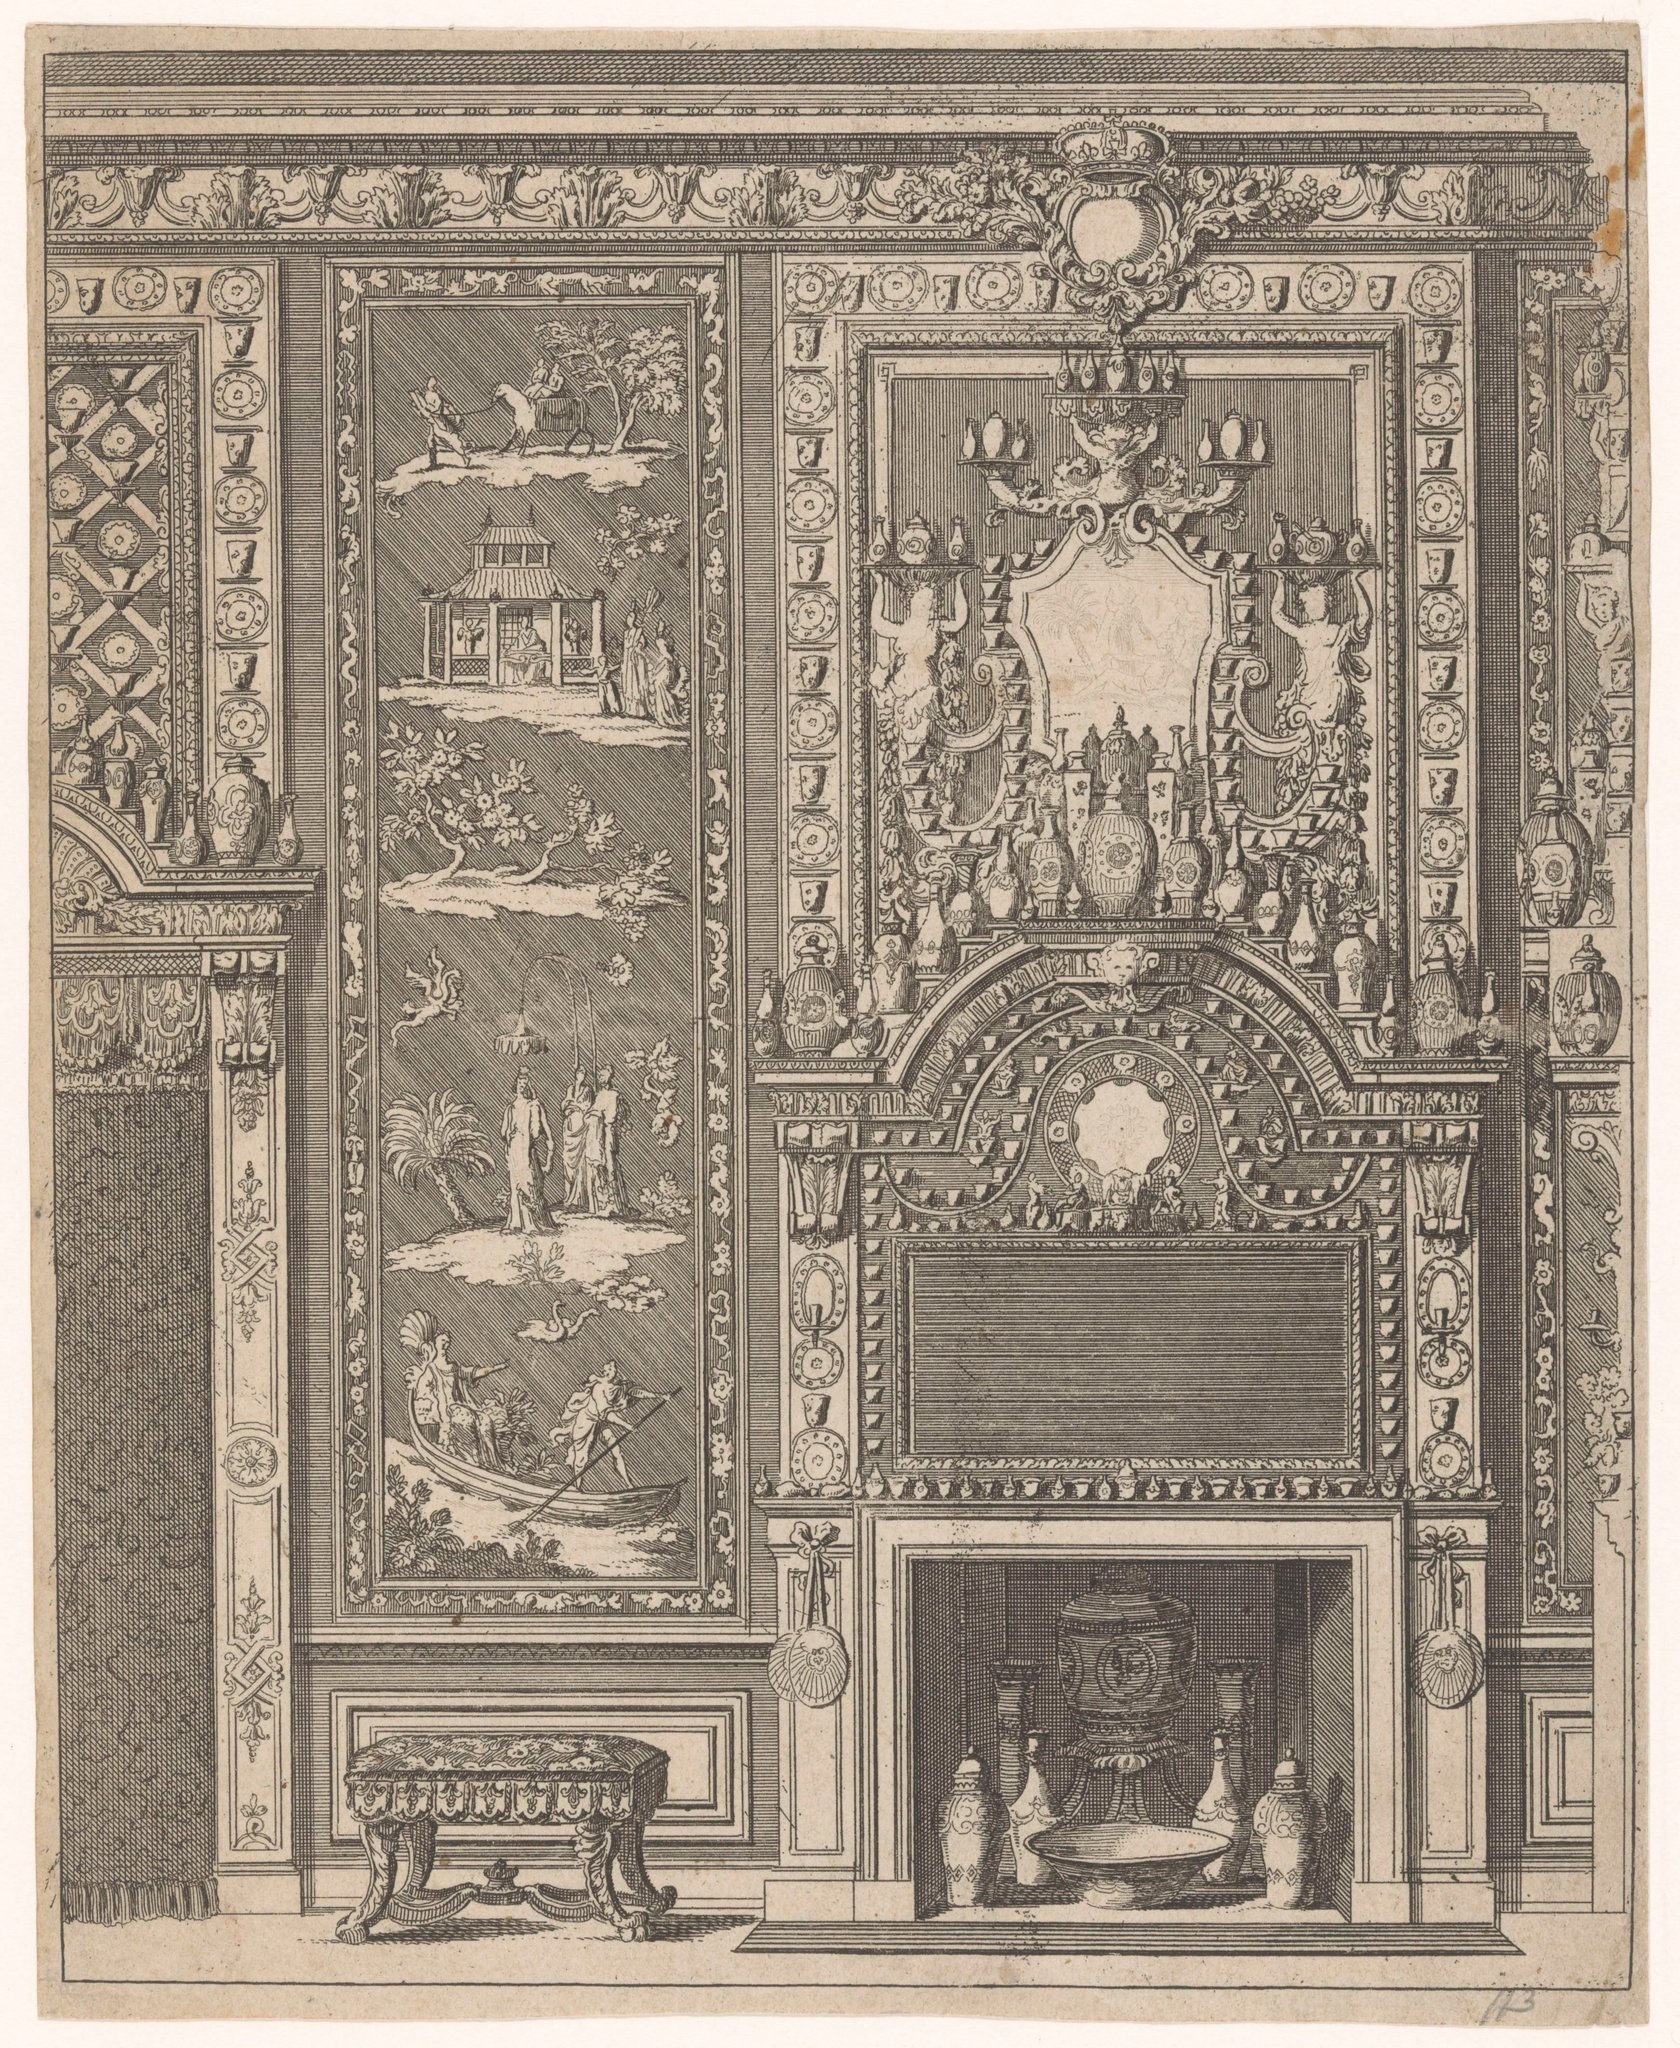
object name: print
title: Schouw voor een wand met lakwerk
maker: Anonymous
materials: paper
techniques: etching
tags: open hearth, fire-place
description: Een schouw voor een wand met lakwerk. Links de helft van een deur met dessus-de-porte. Op de schouw en de kroonlijst van de deur staat een groot aantal Chinese porseleinen vazen.